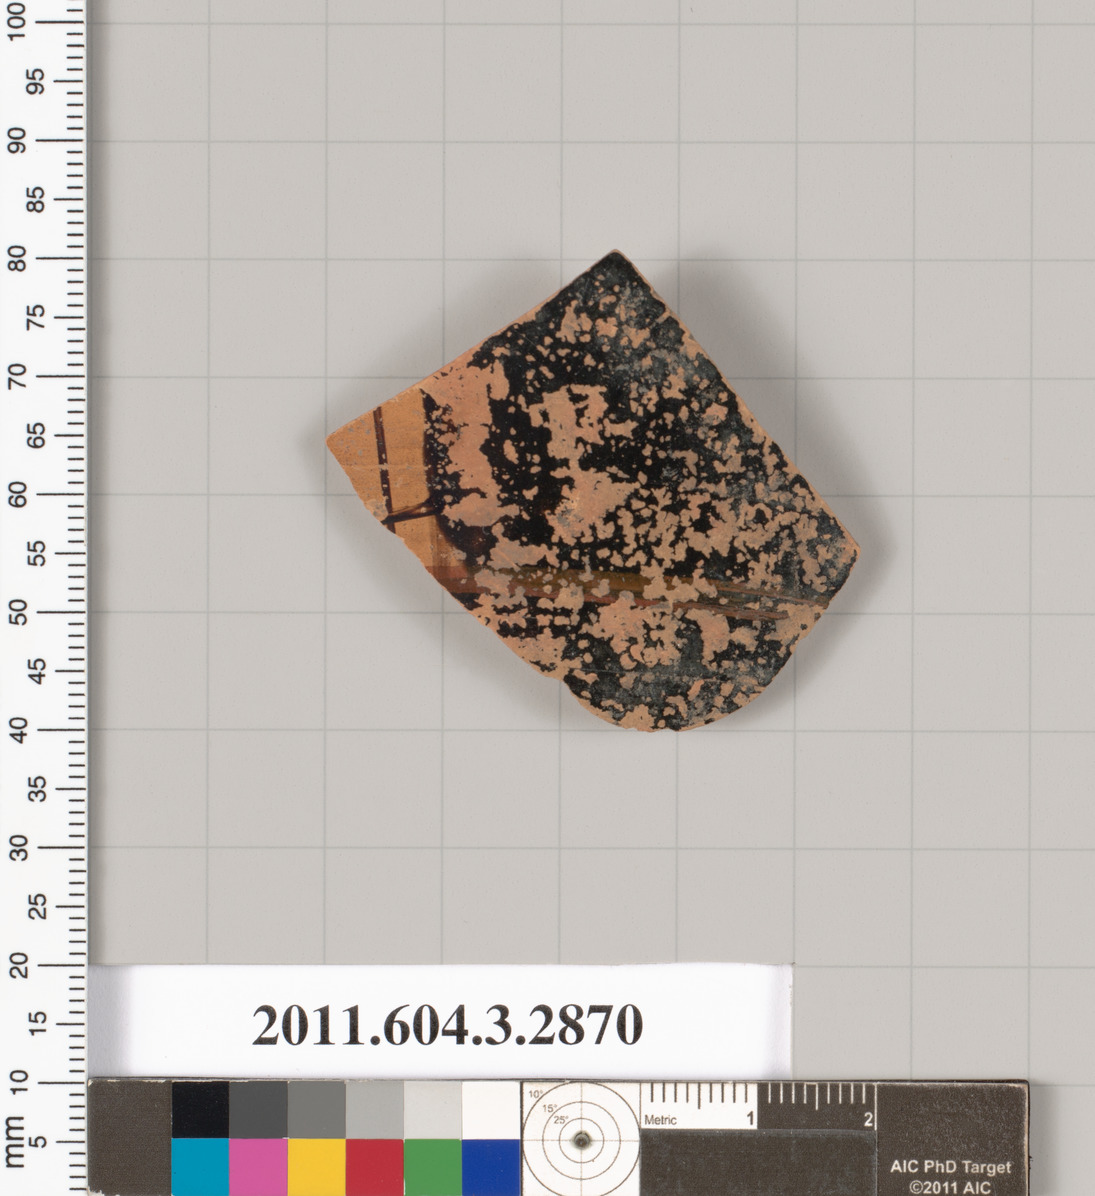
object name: undetermined closed shape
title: Terracotta fragment of a closed shape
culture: greek, attic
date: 600-401 BCE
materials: terracotta